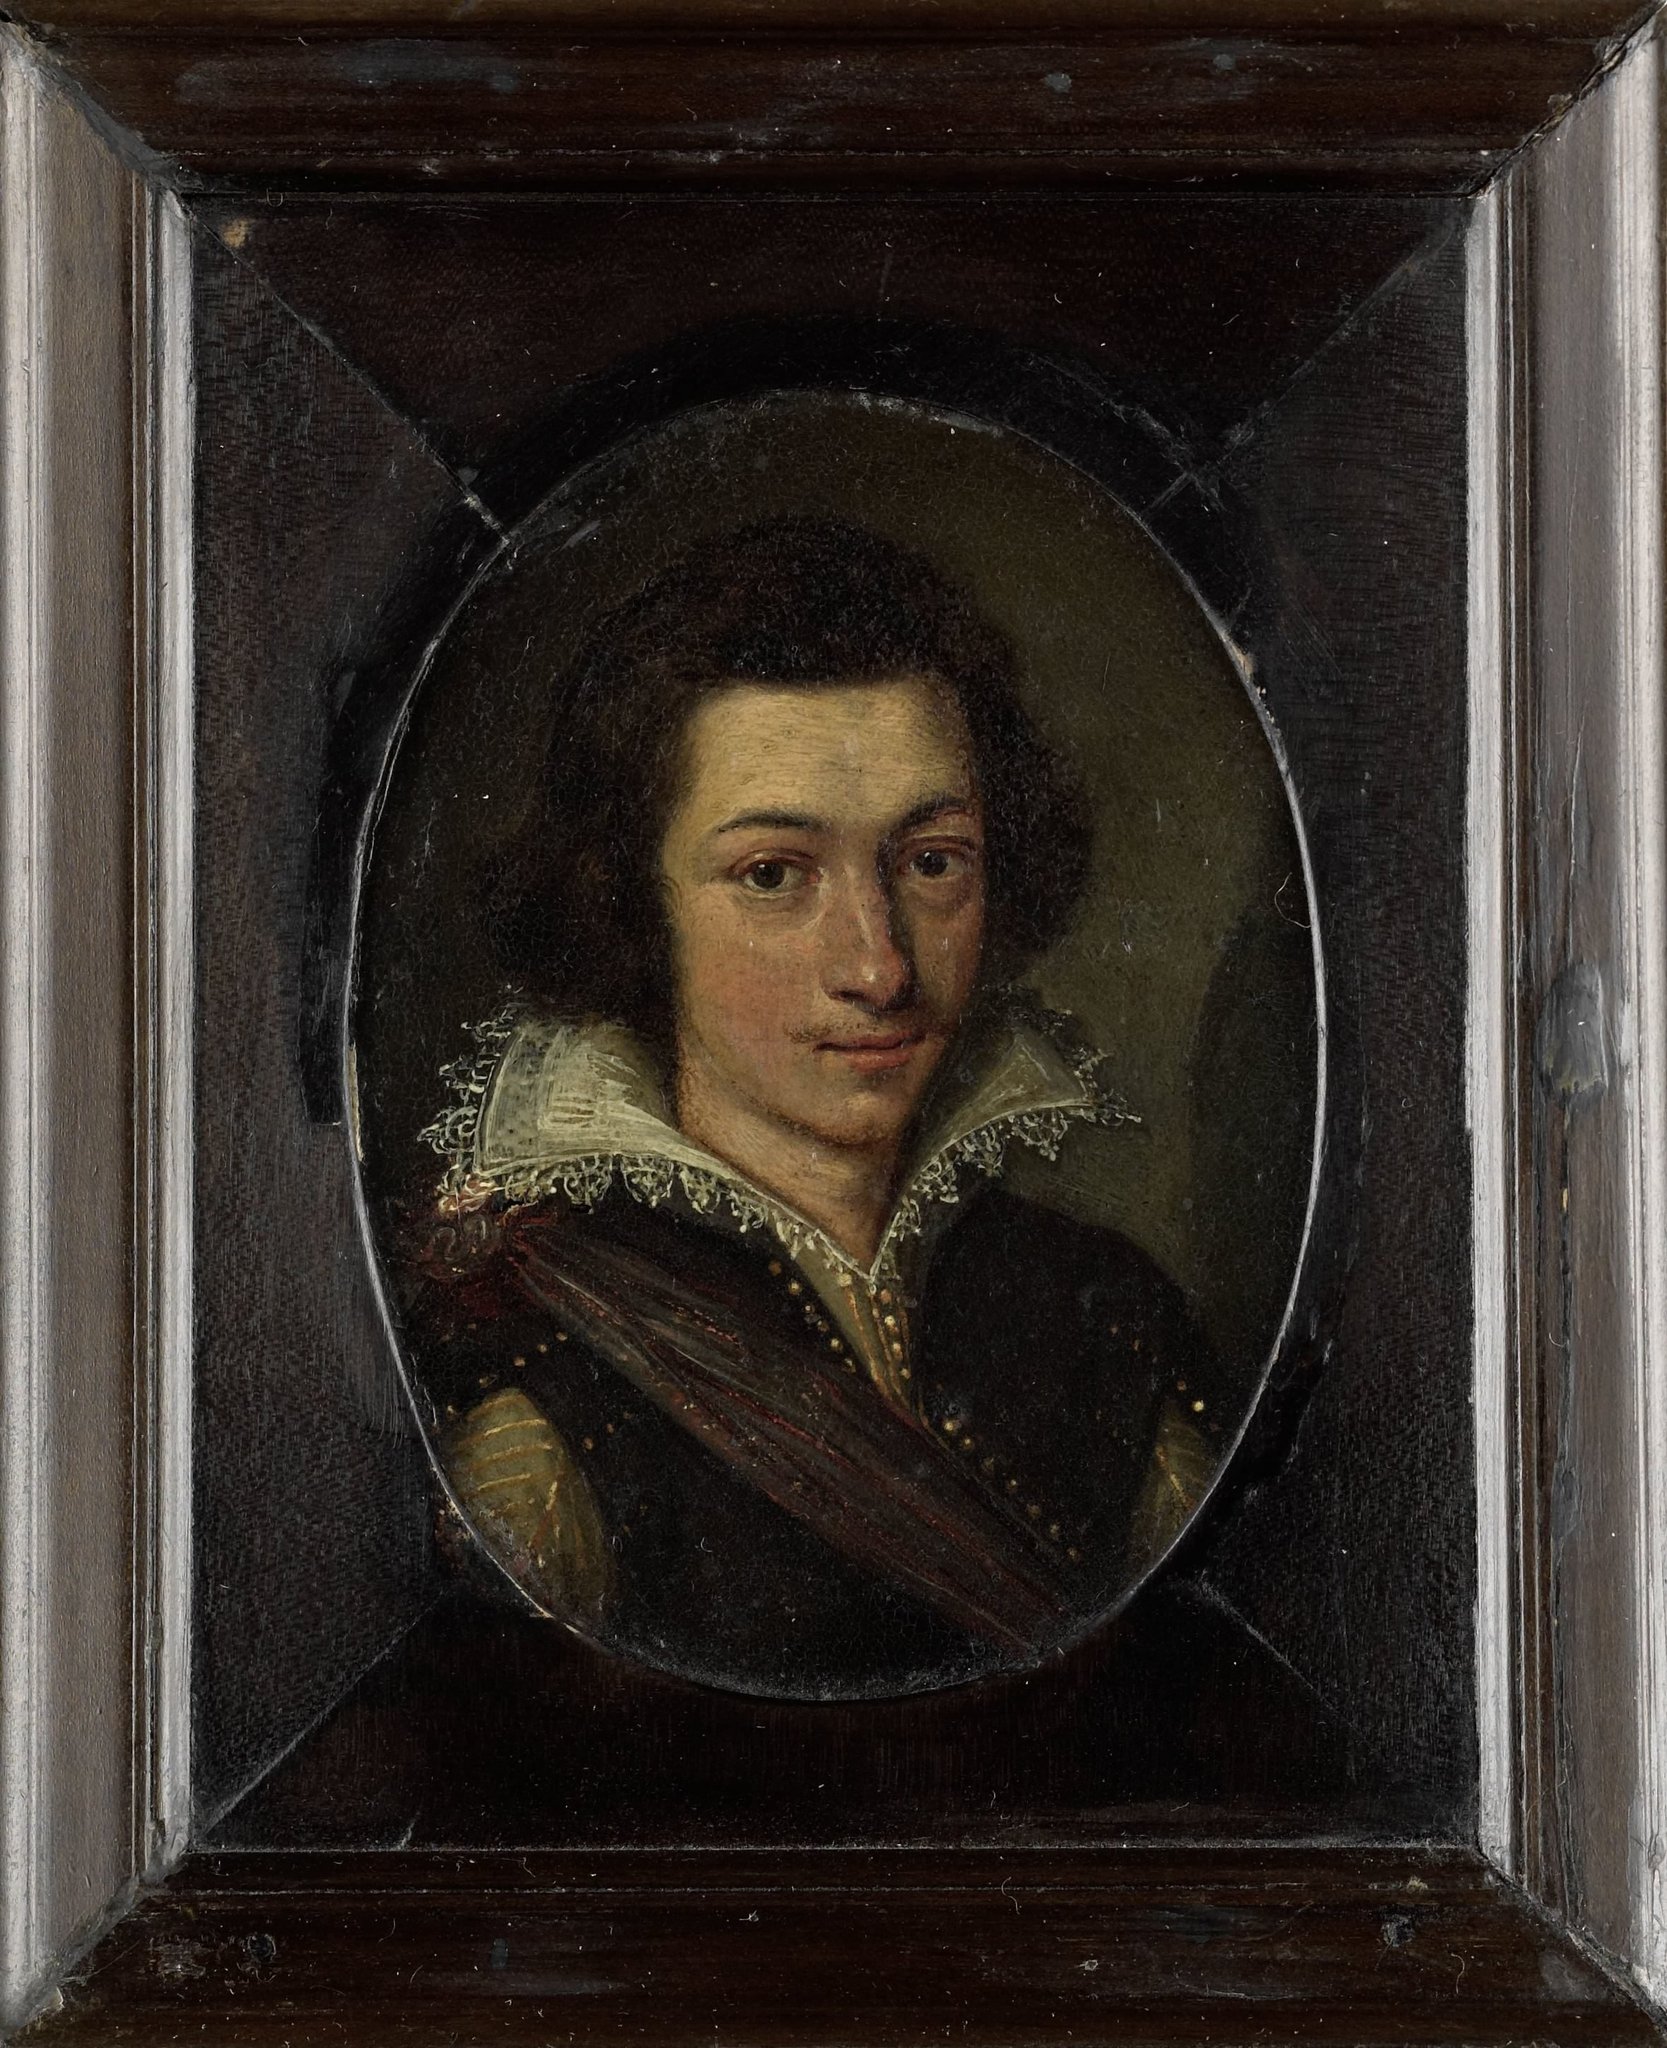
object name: painting, miniature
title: Portret van een jonge man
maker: Anonymous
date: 1614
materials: copper, oil, wood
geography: northern netherlands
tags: anonymous historical person portrayed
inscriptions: date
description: Portret van een jonge man. Buste in ovaal, naar rechts.